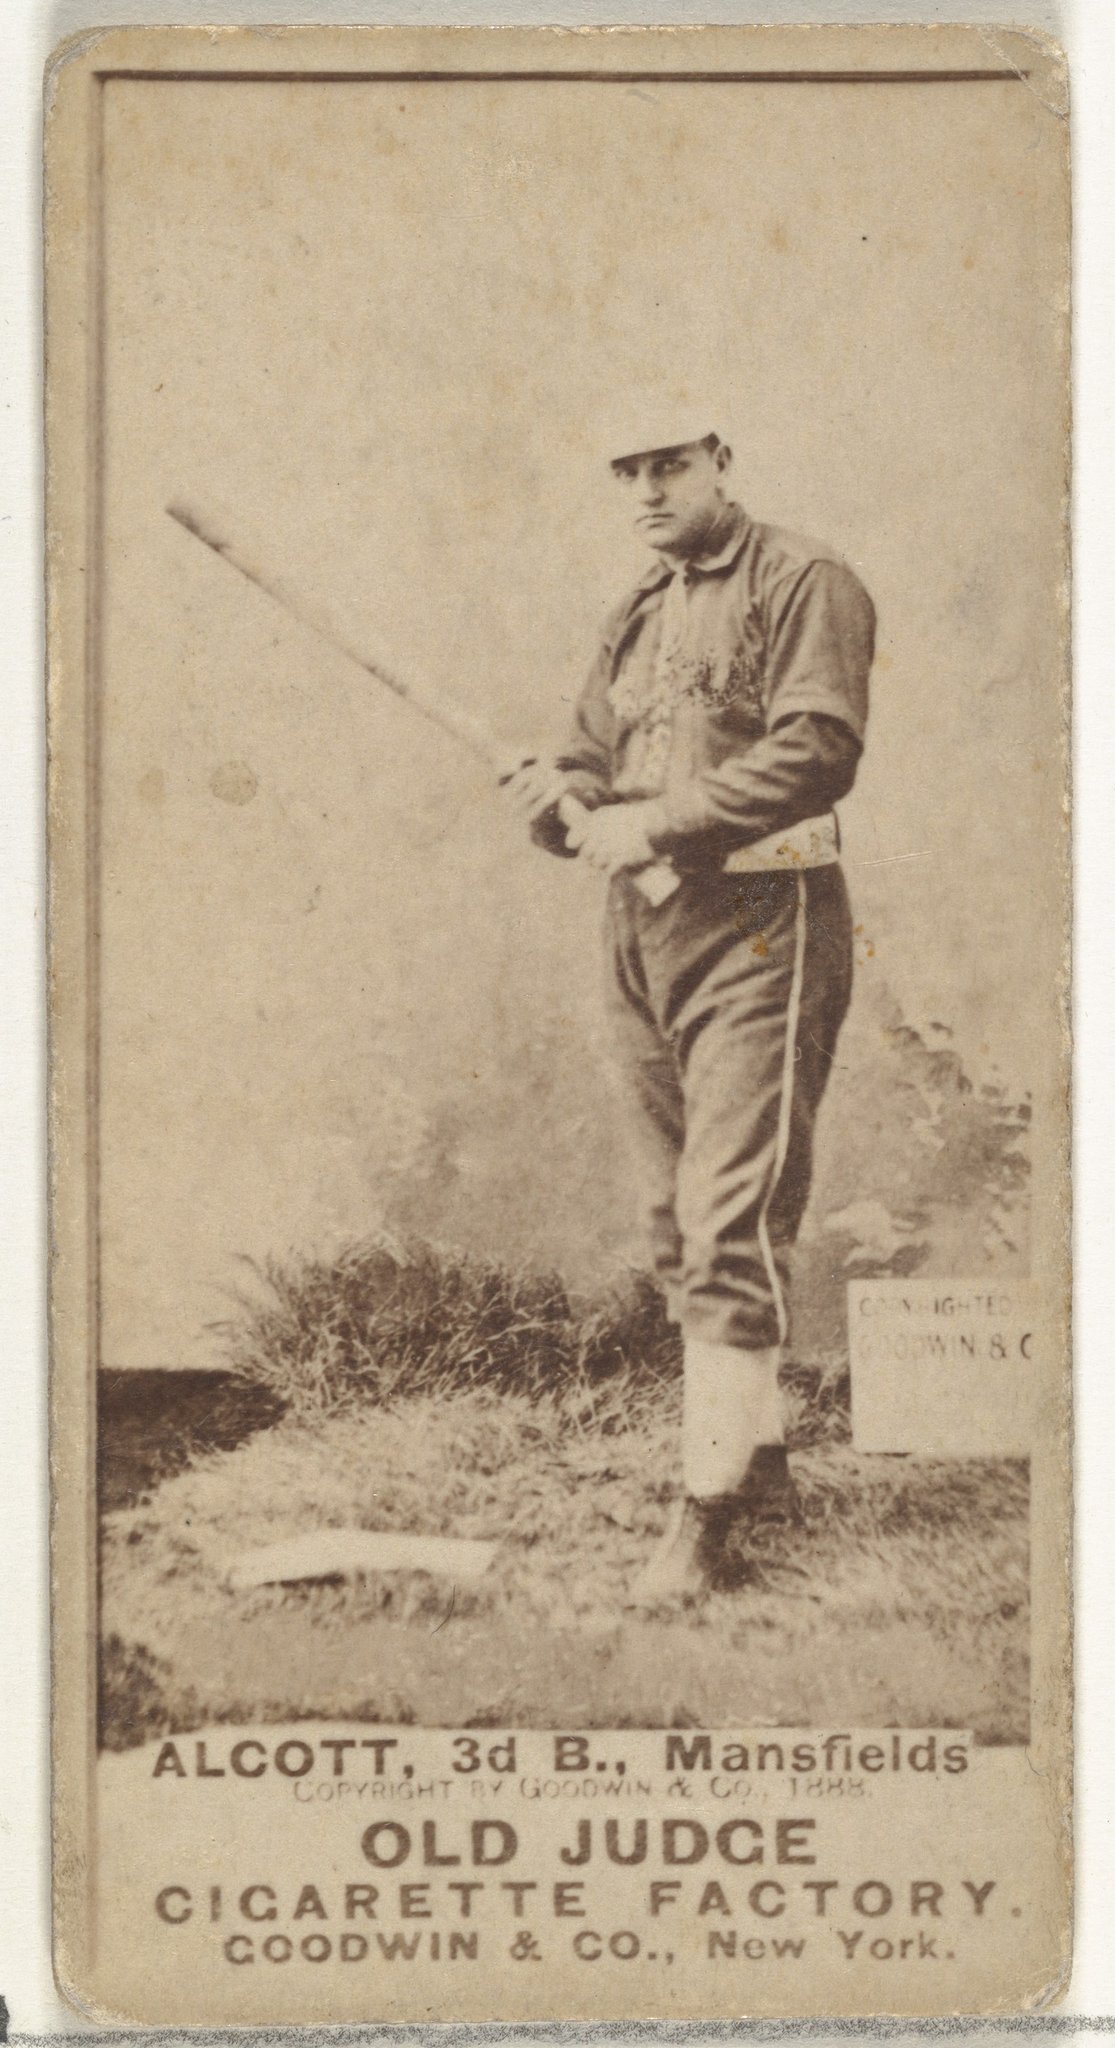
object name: baseball card, photograph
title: Charles Alcott, 3rd Base, Mansfield, from the Old Judge series (N172) for Old Judge Cigarettes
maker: goodwin & company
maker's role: publisher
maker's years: 1850-1950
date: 1888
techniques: albumen silver print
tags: men,portraits,baseball,athletes